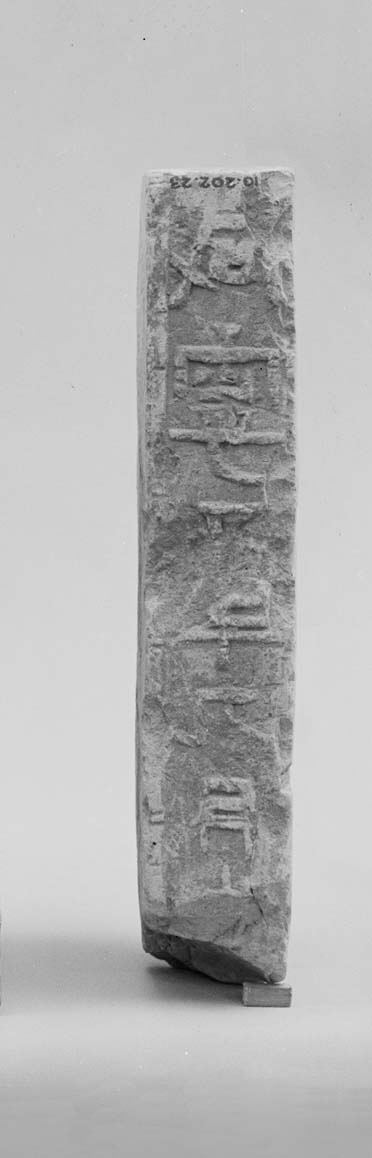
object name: tile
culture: chinese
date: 221 BCE-220 CE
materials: earthenware